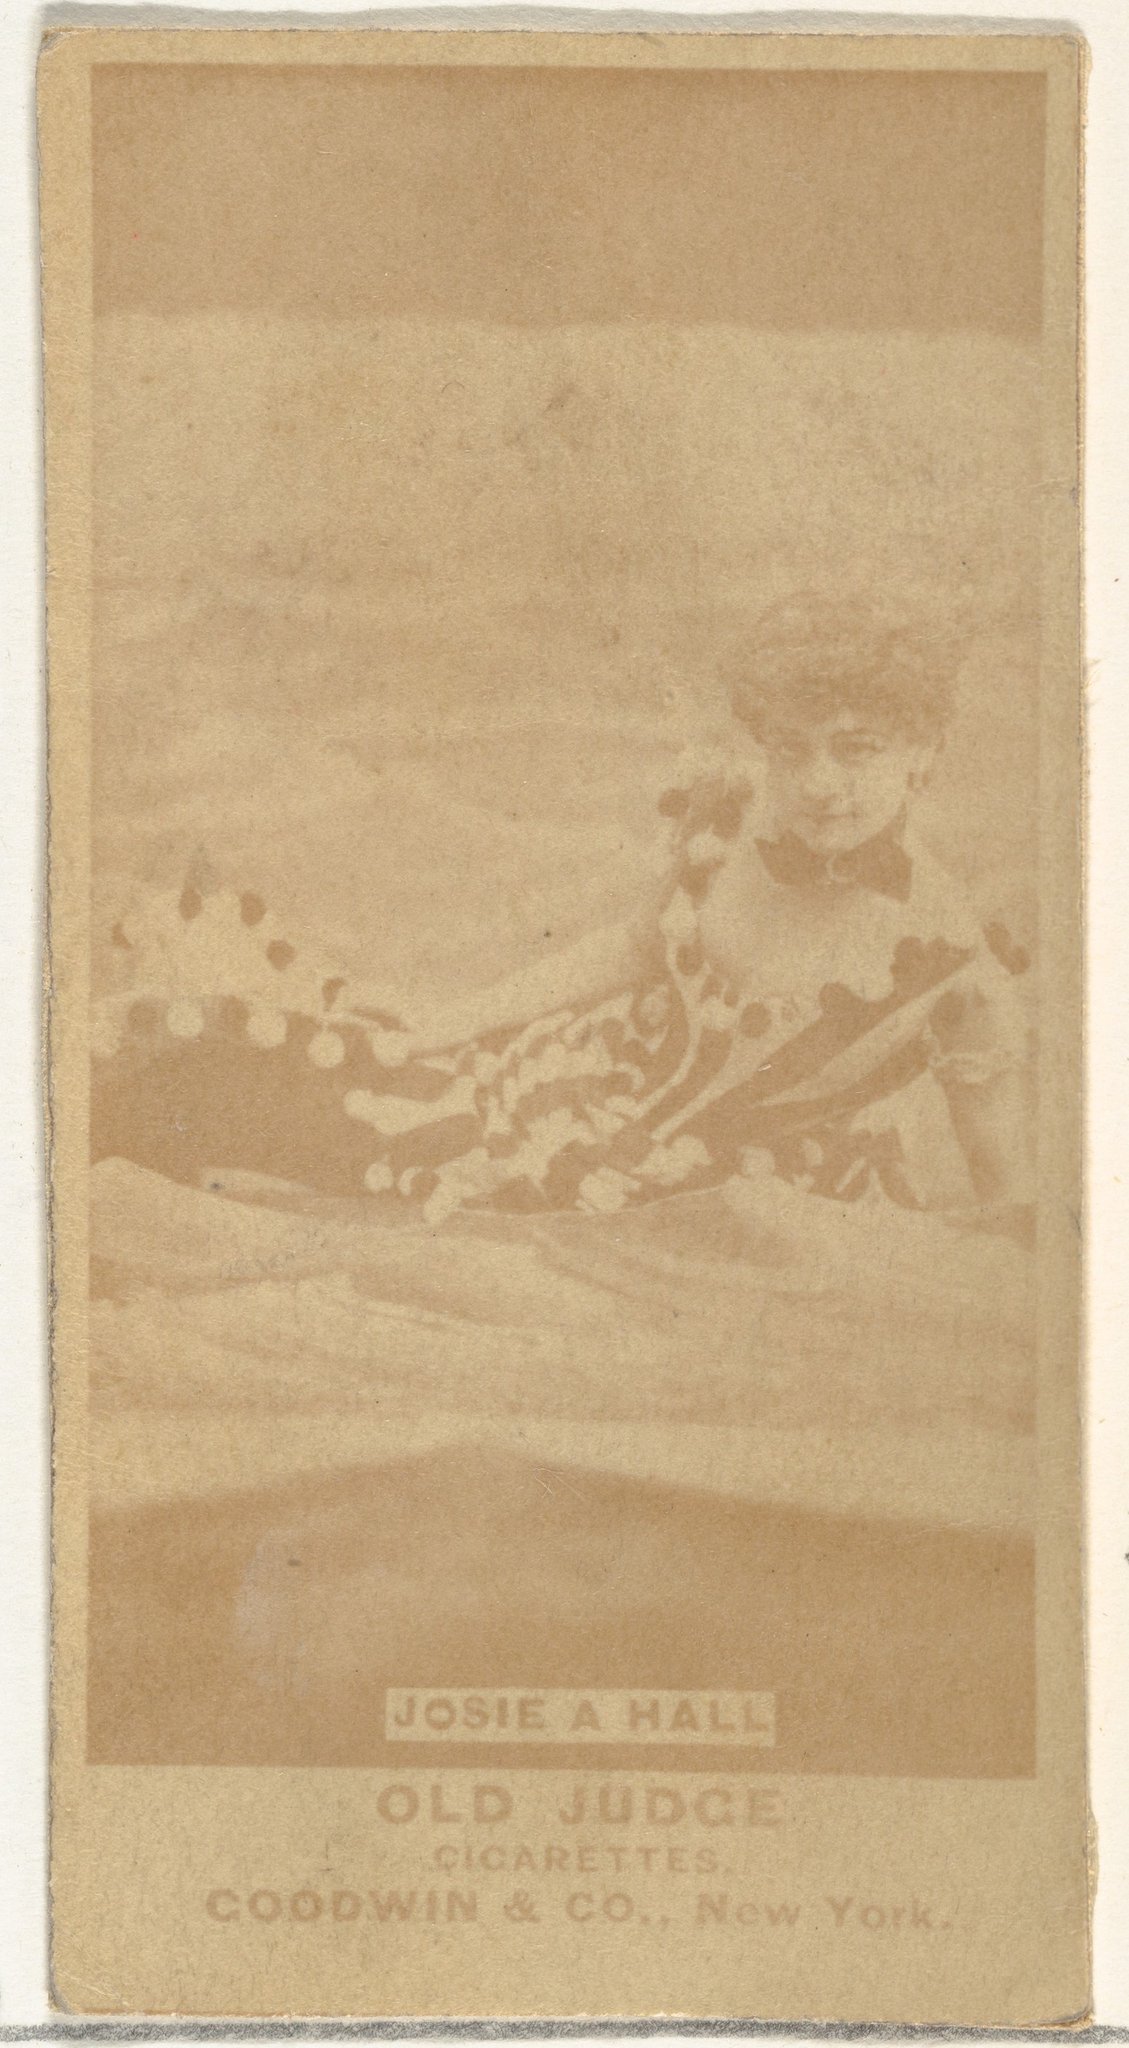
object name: photograph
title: Josie A. Hall, from the Actors and Actresses series (N171) for Old Judge Cigarettes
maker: goodwin & company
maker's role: publisher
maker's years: 1850-1950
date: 1886-1890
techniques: albumen silver print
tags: portraits,women,actresses